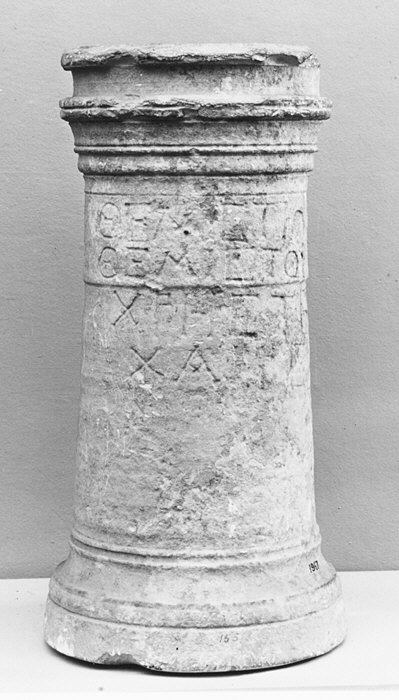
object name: cippus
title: Limestone cippus of Themistion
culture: roman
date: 1-100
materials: limestone